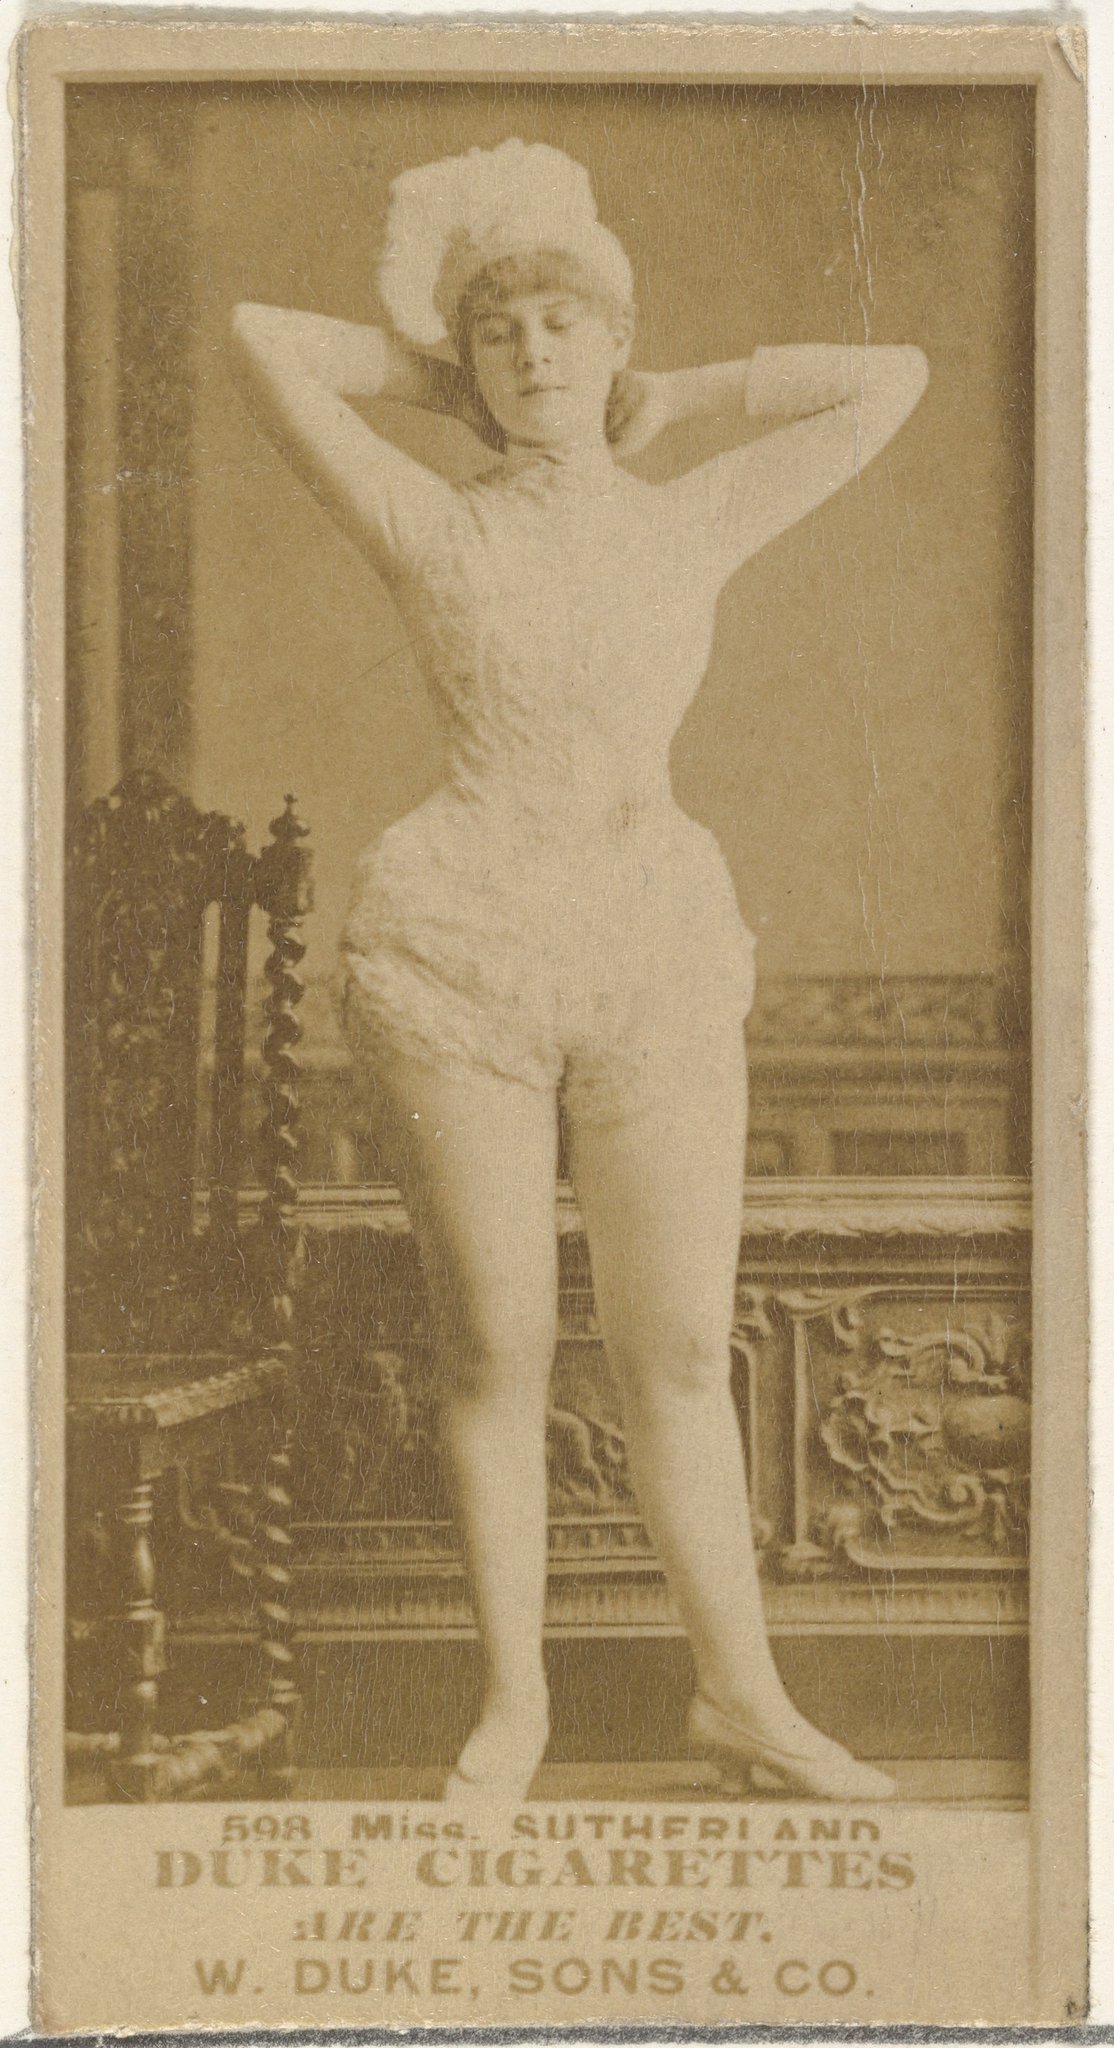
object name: photograph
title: Card Number 598, Miss Sutherland, from the Actors and Actresses series (N145-7) issued by Duke Sons & Co. to promote Duke Cigarettes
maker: w. duke, sons & co.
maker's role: publisher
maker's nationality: american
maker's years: 1870-1920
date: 1880-1889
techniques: albumen silver print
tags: portraits,women,actresses